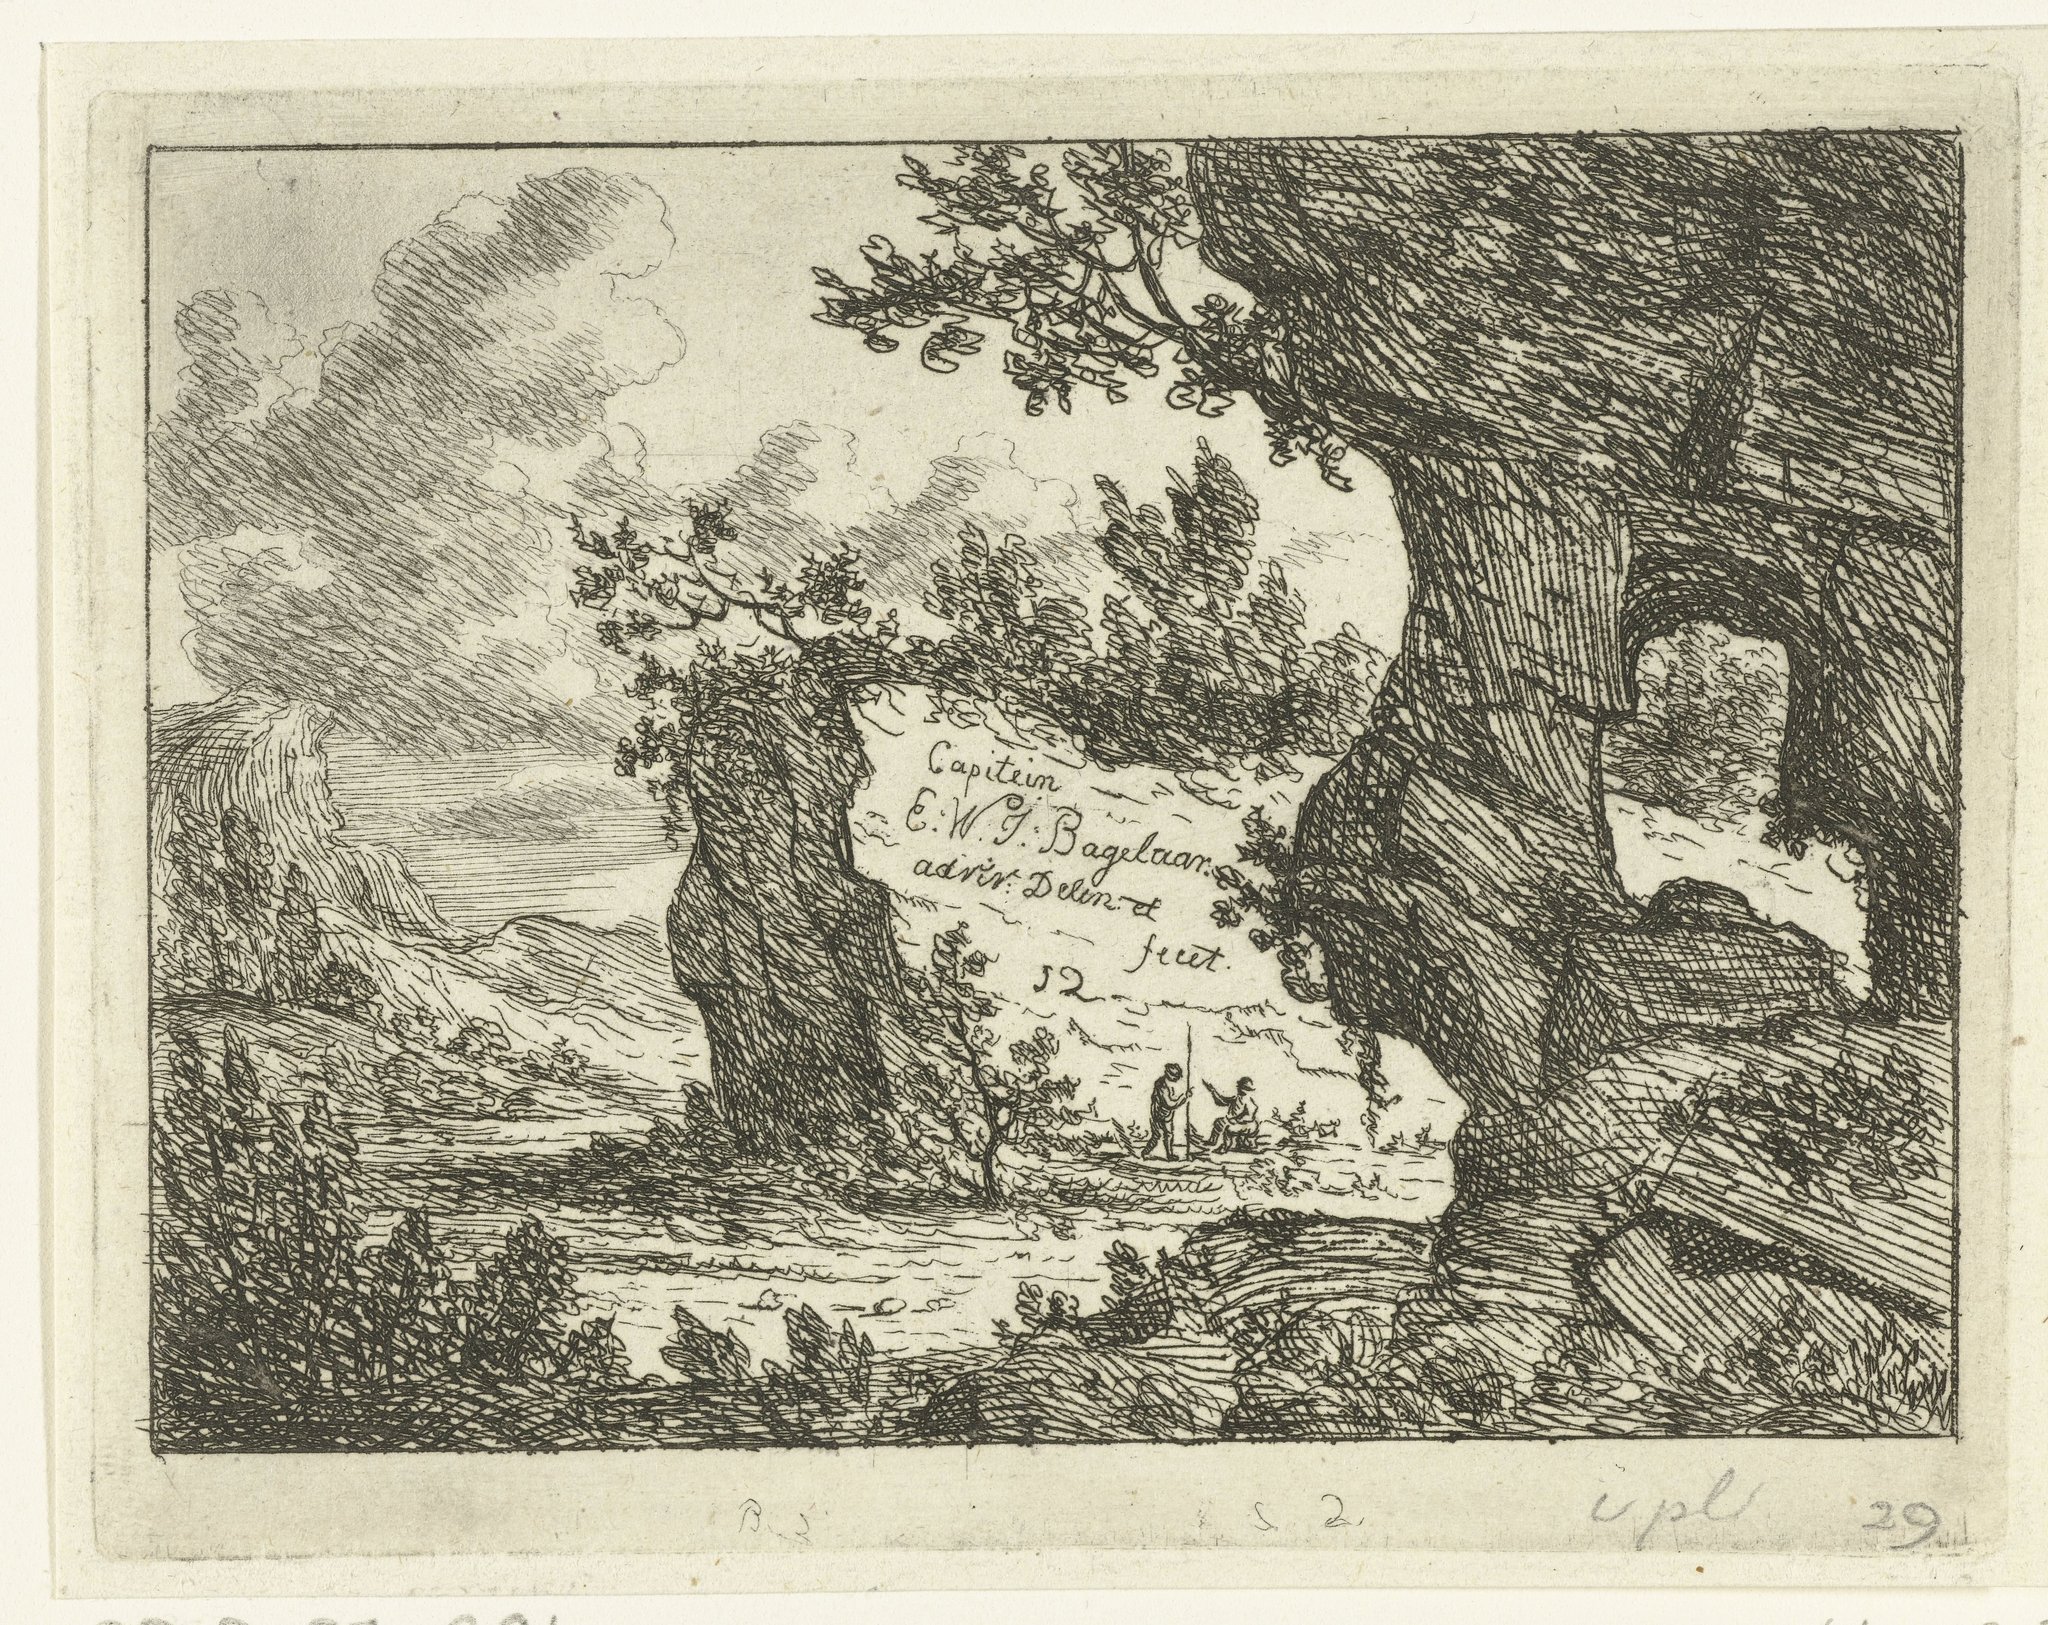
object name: print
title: Rotslandschap met twee wandelaars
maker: ernst willem jan bagelaar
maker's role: draughtsman, print maker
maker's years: 1775-1837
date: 1798-1837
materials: paper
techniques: drypoint, etching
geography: netherlands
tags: rocks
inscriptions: collector's mark: Lugt 2228